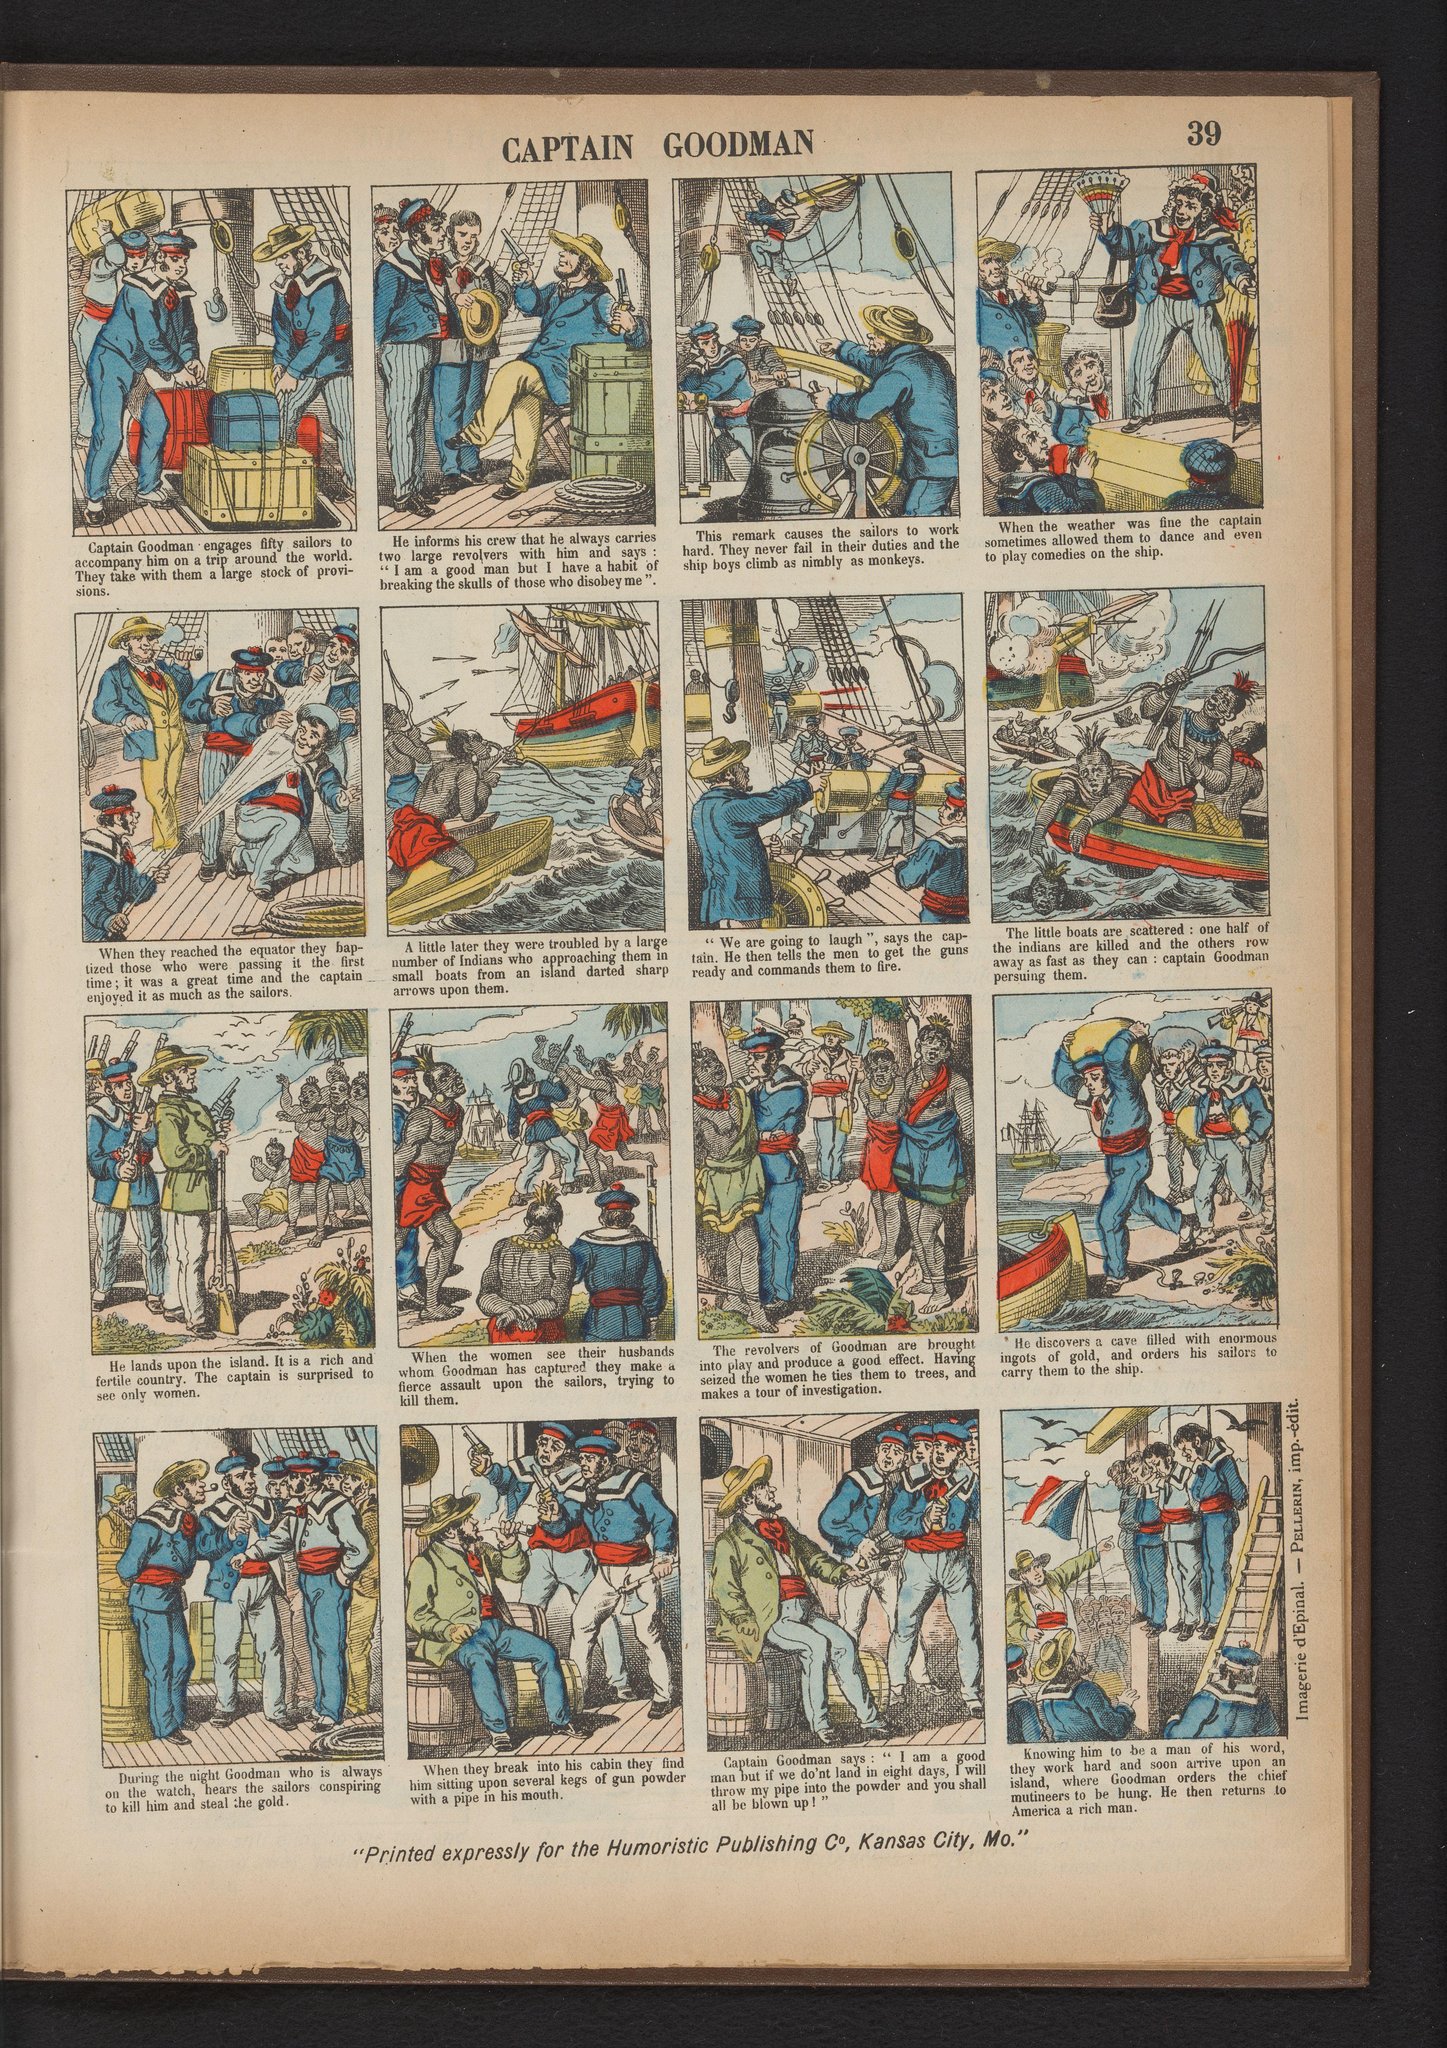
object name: print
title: Captain Goodman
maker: Anonymous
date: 1893-1894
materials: paper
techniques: colour, letterpress printing, lithograph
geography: kansas city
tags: literary characters and objects, seaman, minerals and metals: gold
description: Blad met zestien voorstellingen over scheepskapitein Goodman. Onder elke voorstelling een onderschrift in het Engels. Deze prent maakt deel uit van een album.